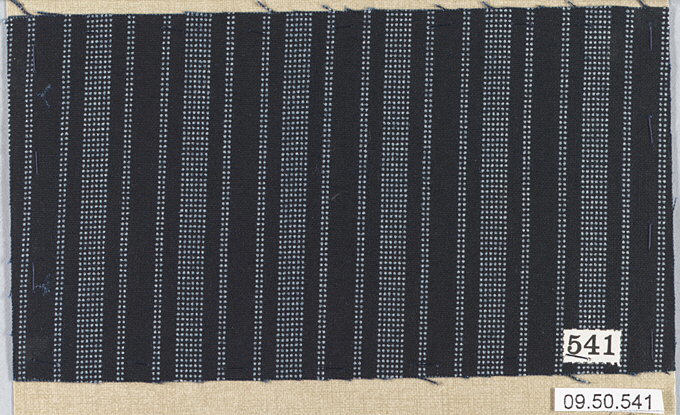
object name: piece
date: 1801-1900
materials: cotton